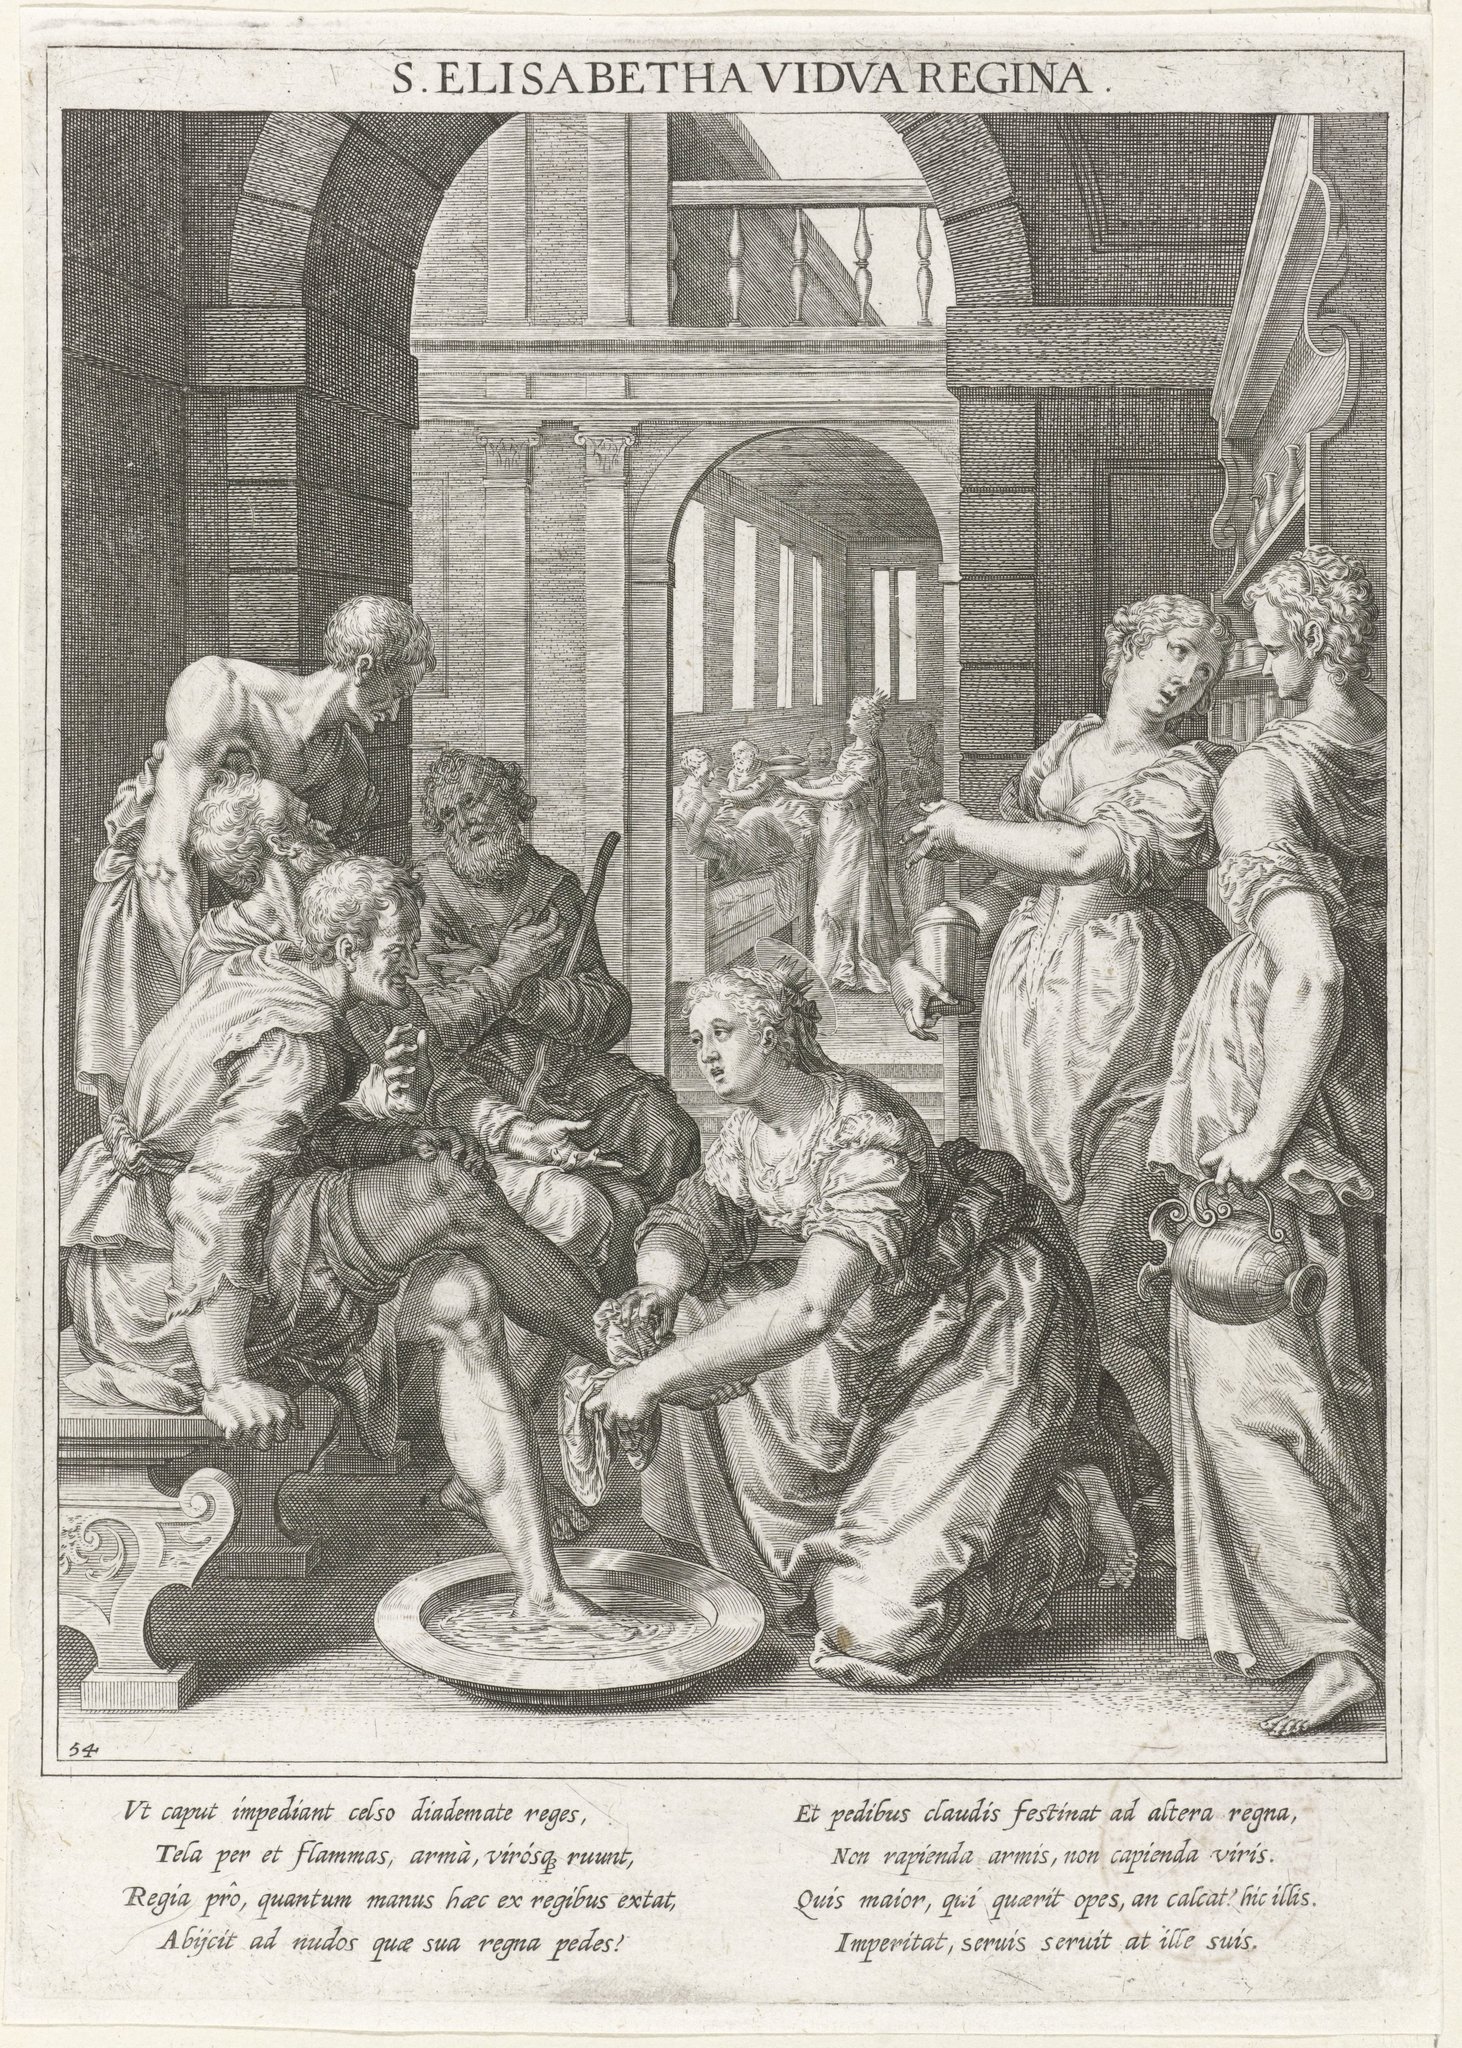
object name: print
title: Liefdadigheid van de Heilige Elisabet van Hongarije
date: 1615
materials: paper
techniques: engraving, etching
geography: munich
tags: st. elisabeth giving food to the sick and poor, st. elisabeth washing the feet of the poor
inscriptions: collector's mark: Lugt 240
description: Op de voorgrond wast de H. Elisabet, koningin van Hongarije, de voeten van bedelaars. Op de achtergrond deelt zij voedsel uit aan de noodlijdenden. De prent heeft een Latijns onderschrift en is de 54ste prent van een 60-delige serie met als onderwerp de heiligen van Beieren.